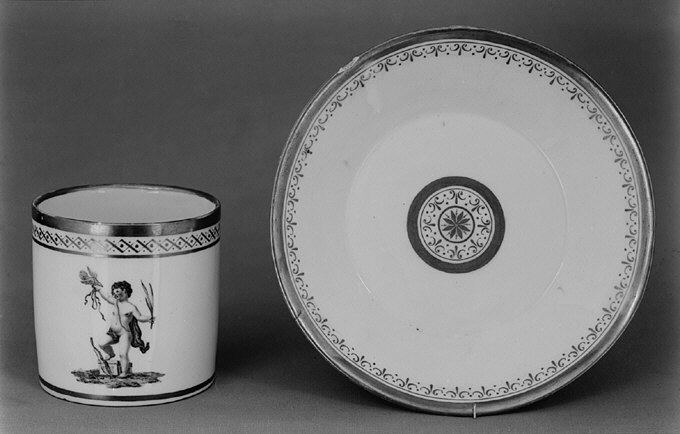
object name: cup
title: Cup (part of a coffee service)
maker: nymphenburg porcelain manufactory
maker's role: manufactory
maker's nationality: german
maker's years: 1747-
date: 1801-1833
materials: hard paste porcelain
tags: cupid